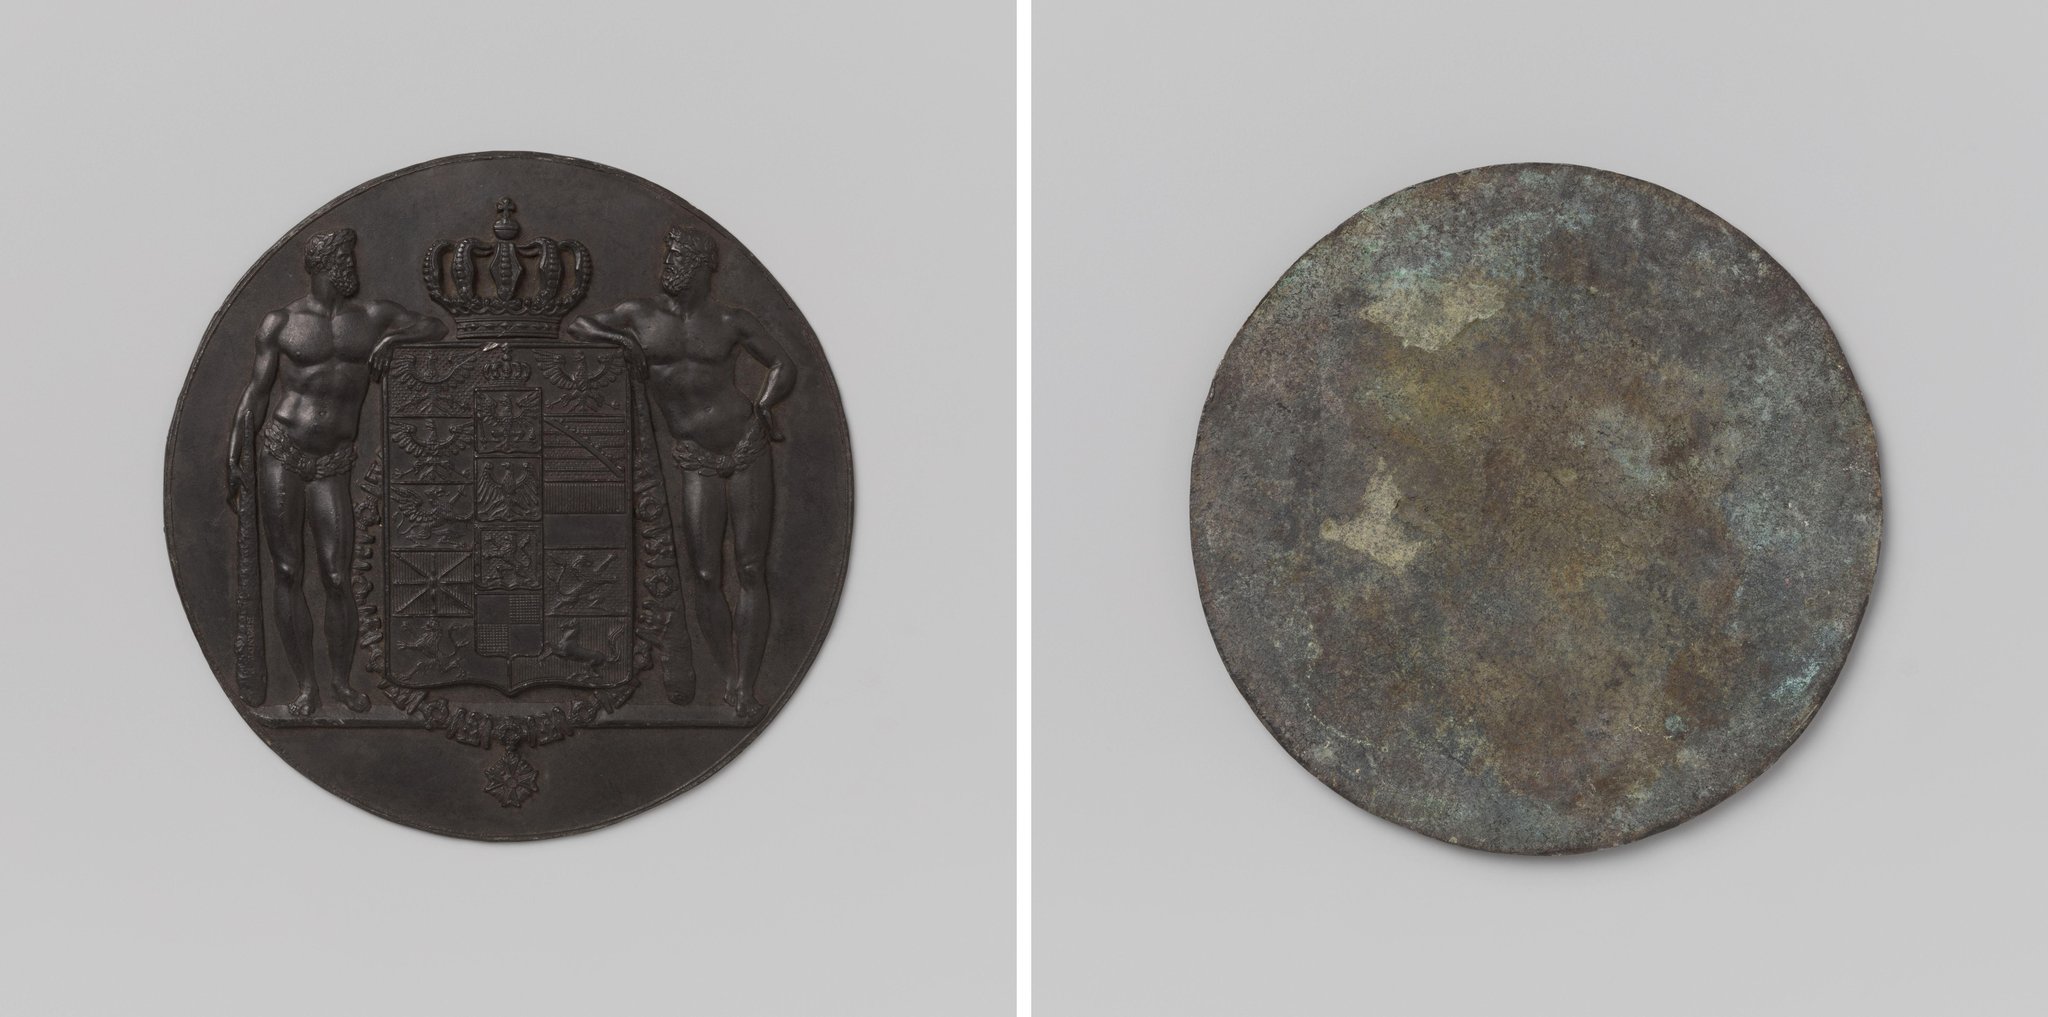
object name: plaque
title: Wapenschild van Pruisen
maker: henri-françois brandt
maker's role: painter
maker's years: 1789-1845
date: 1817-1845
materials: iron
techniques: casting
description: eenzijdige plaquette. Voorzijde: gekroond wapenschild, omhangen met ordeteken en geflankeerd door twee half naakte mannen met knots. Keerzijde: blanco